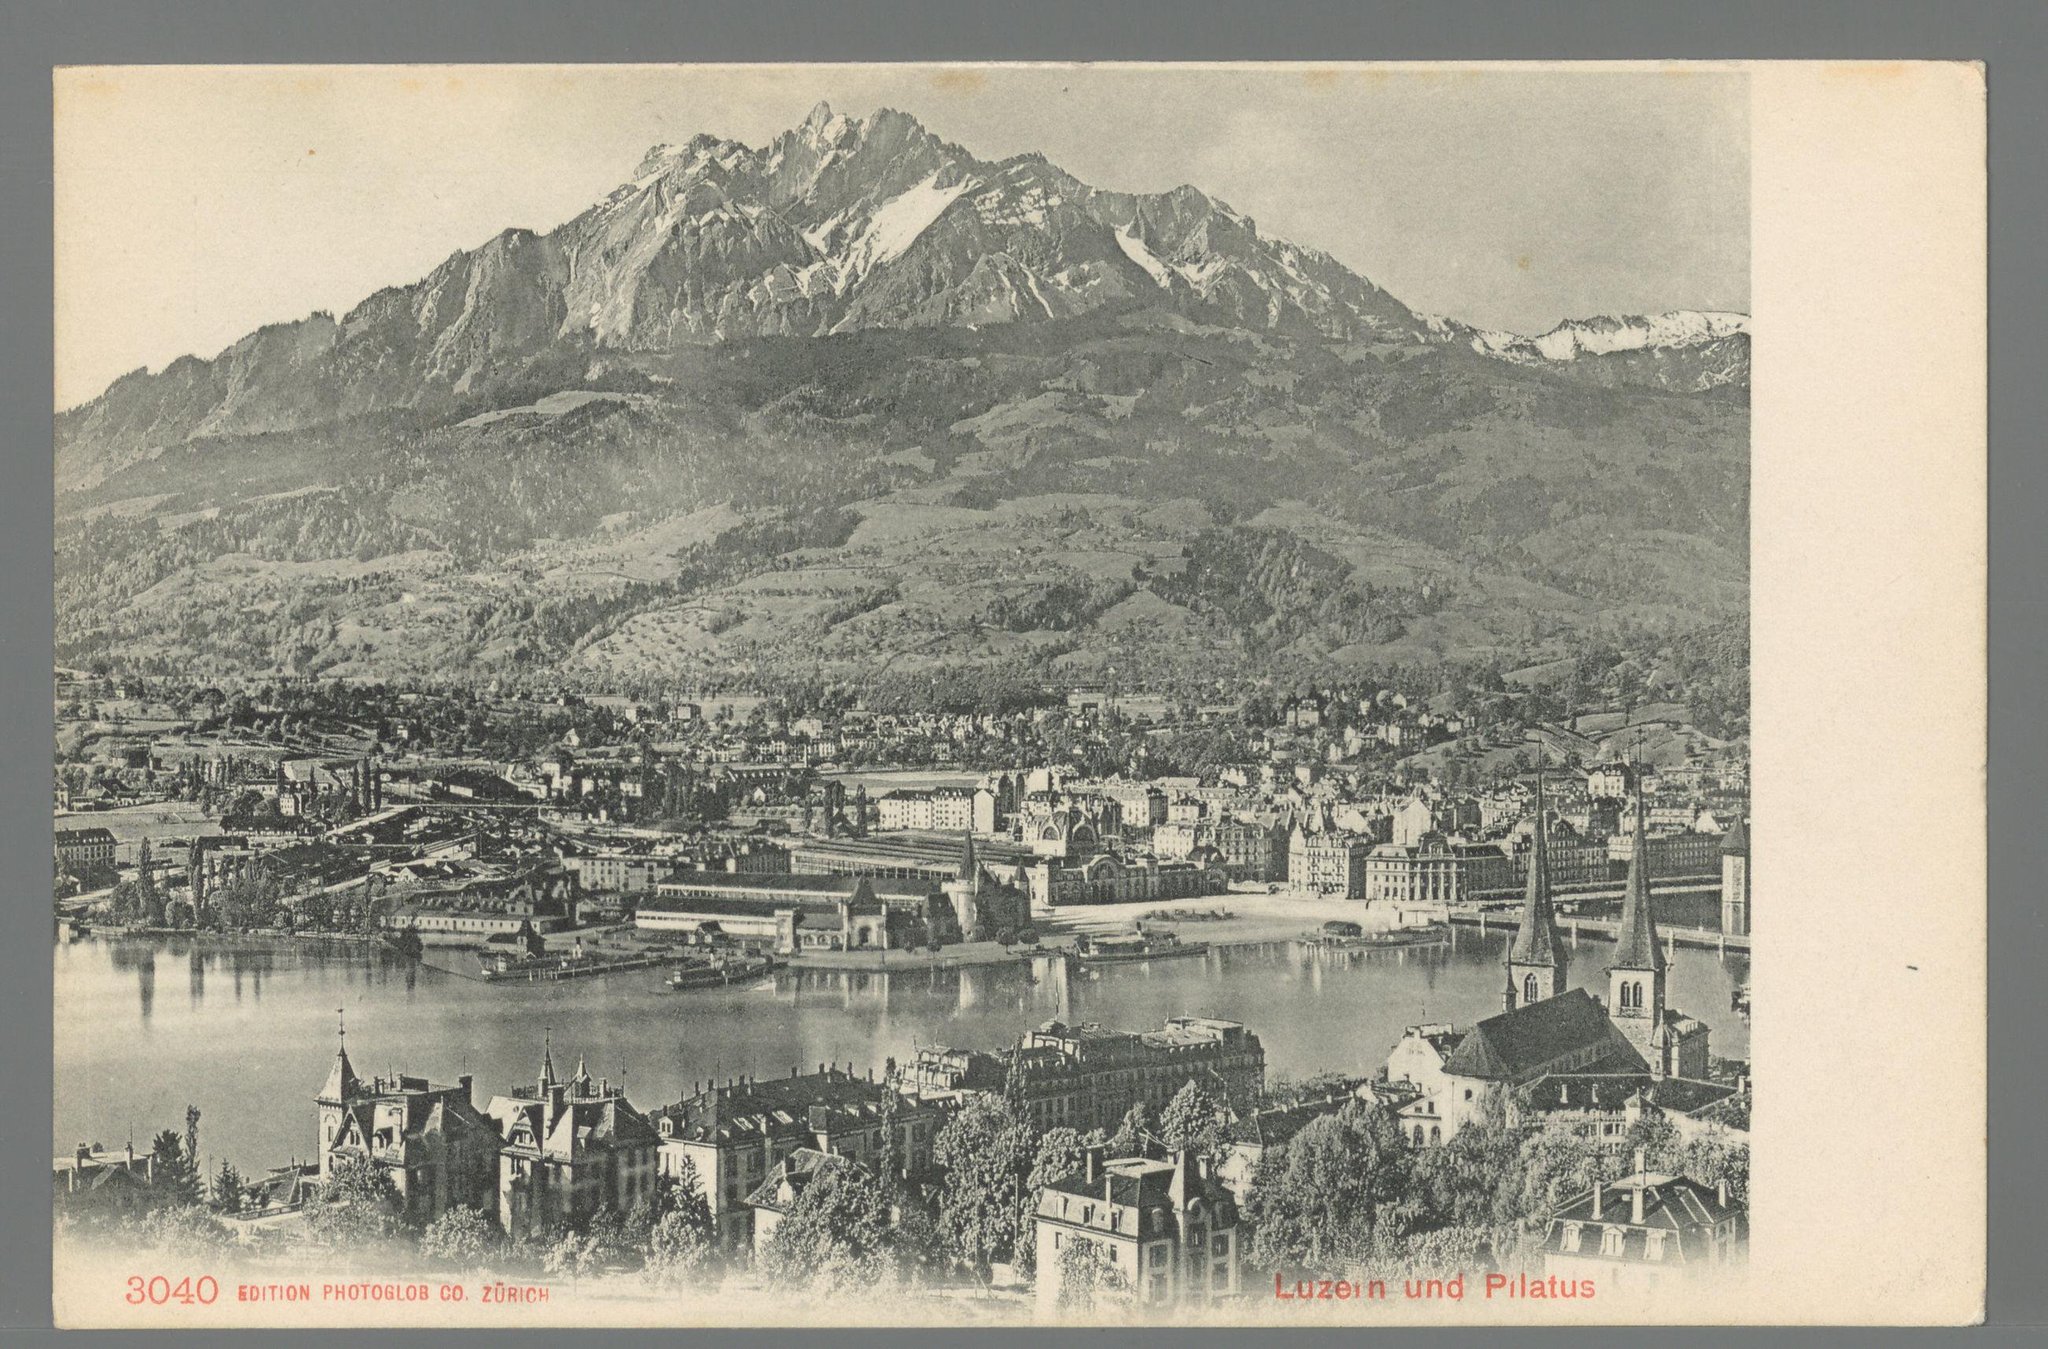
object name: photomechanical print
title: Luzern und Pilatus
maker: Anonymous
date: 1905-1920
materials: cardboard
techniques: photograph, writing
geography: lucerne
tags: lake, mountain-range, snow peaks, prospect of city, town panorama, silhouette of city